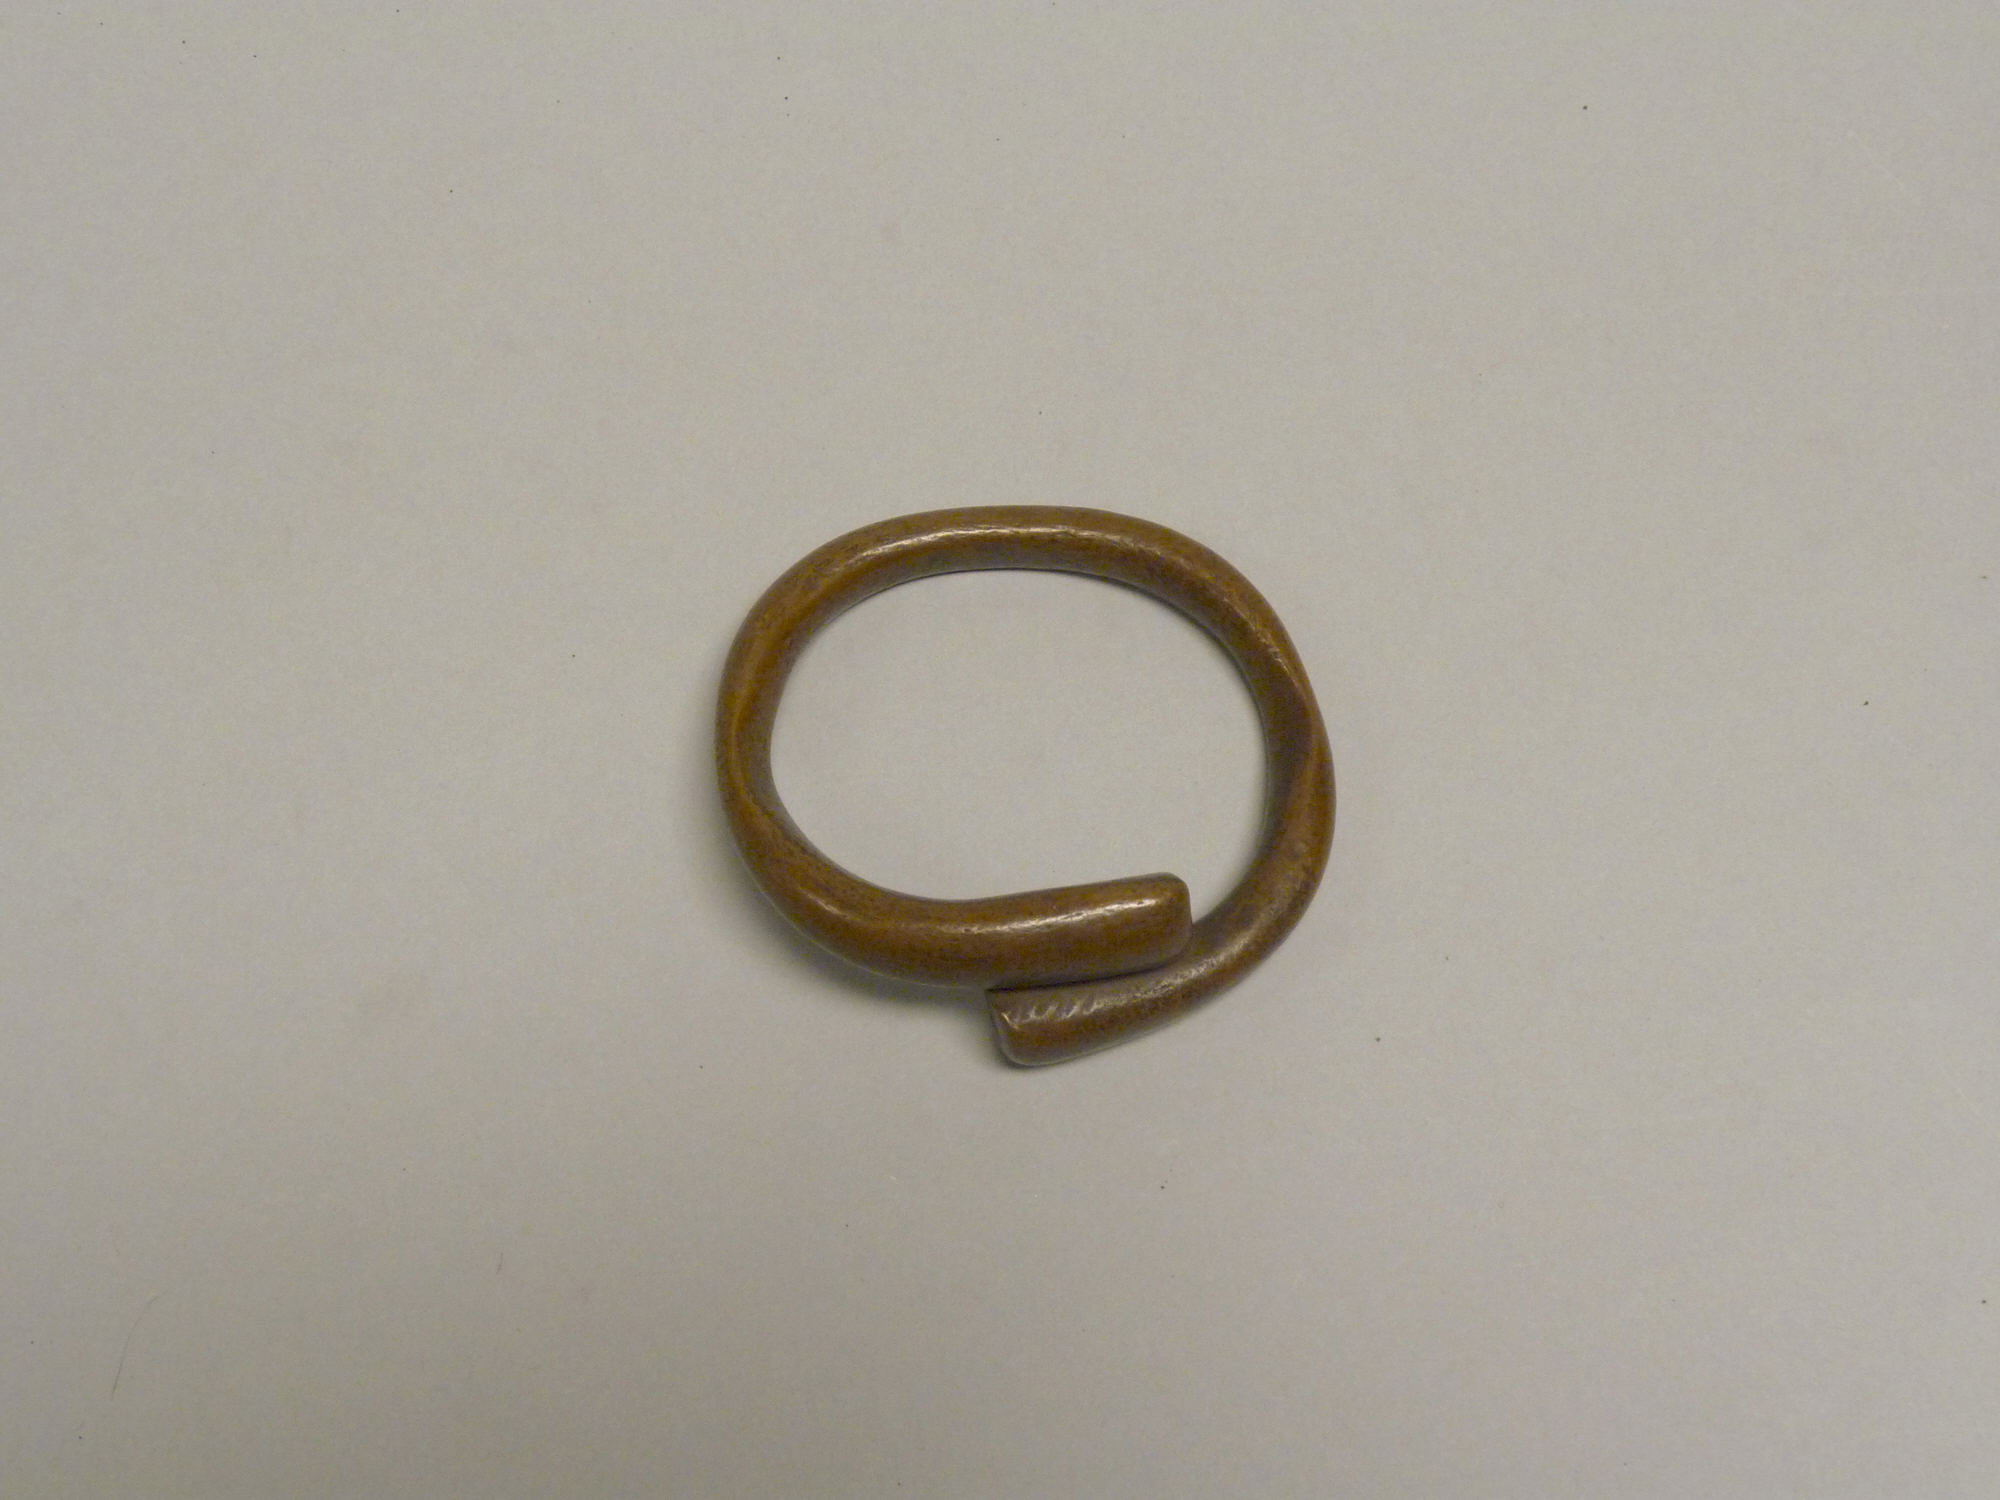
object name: bangle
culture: vietnamese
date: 500 BCE-300 CE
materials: bronze